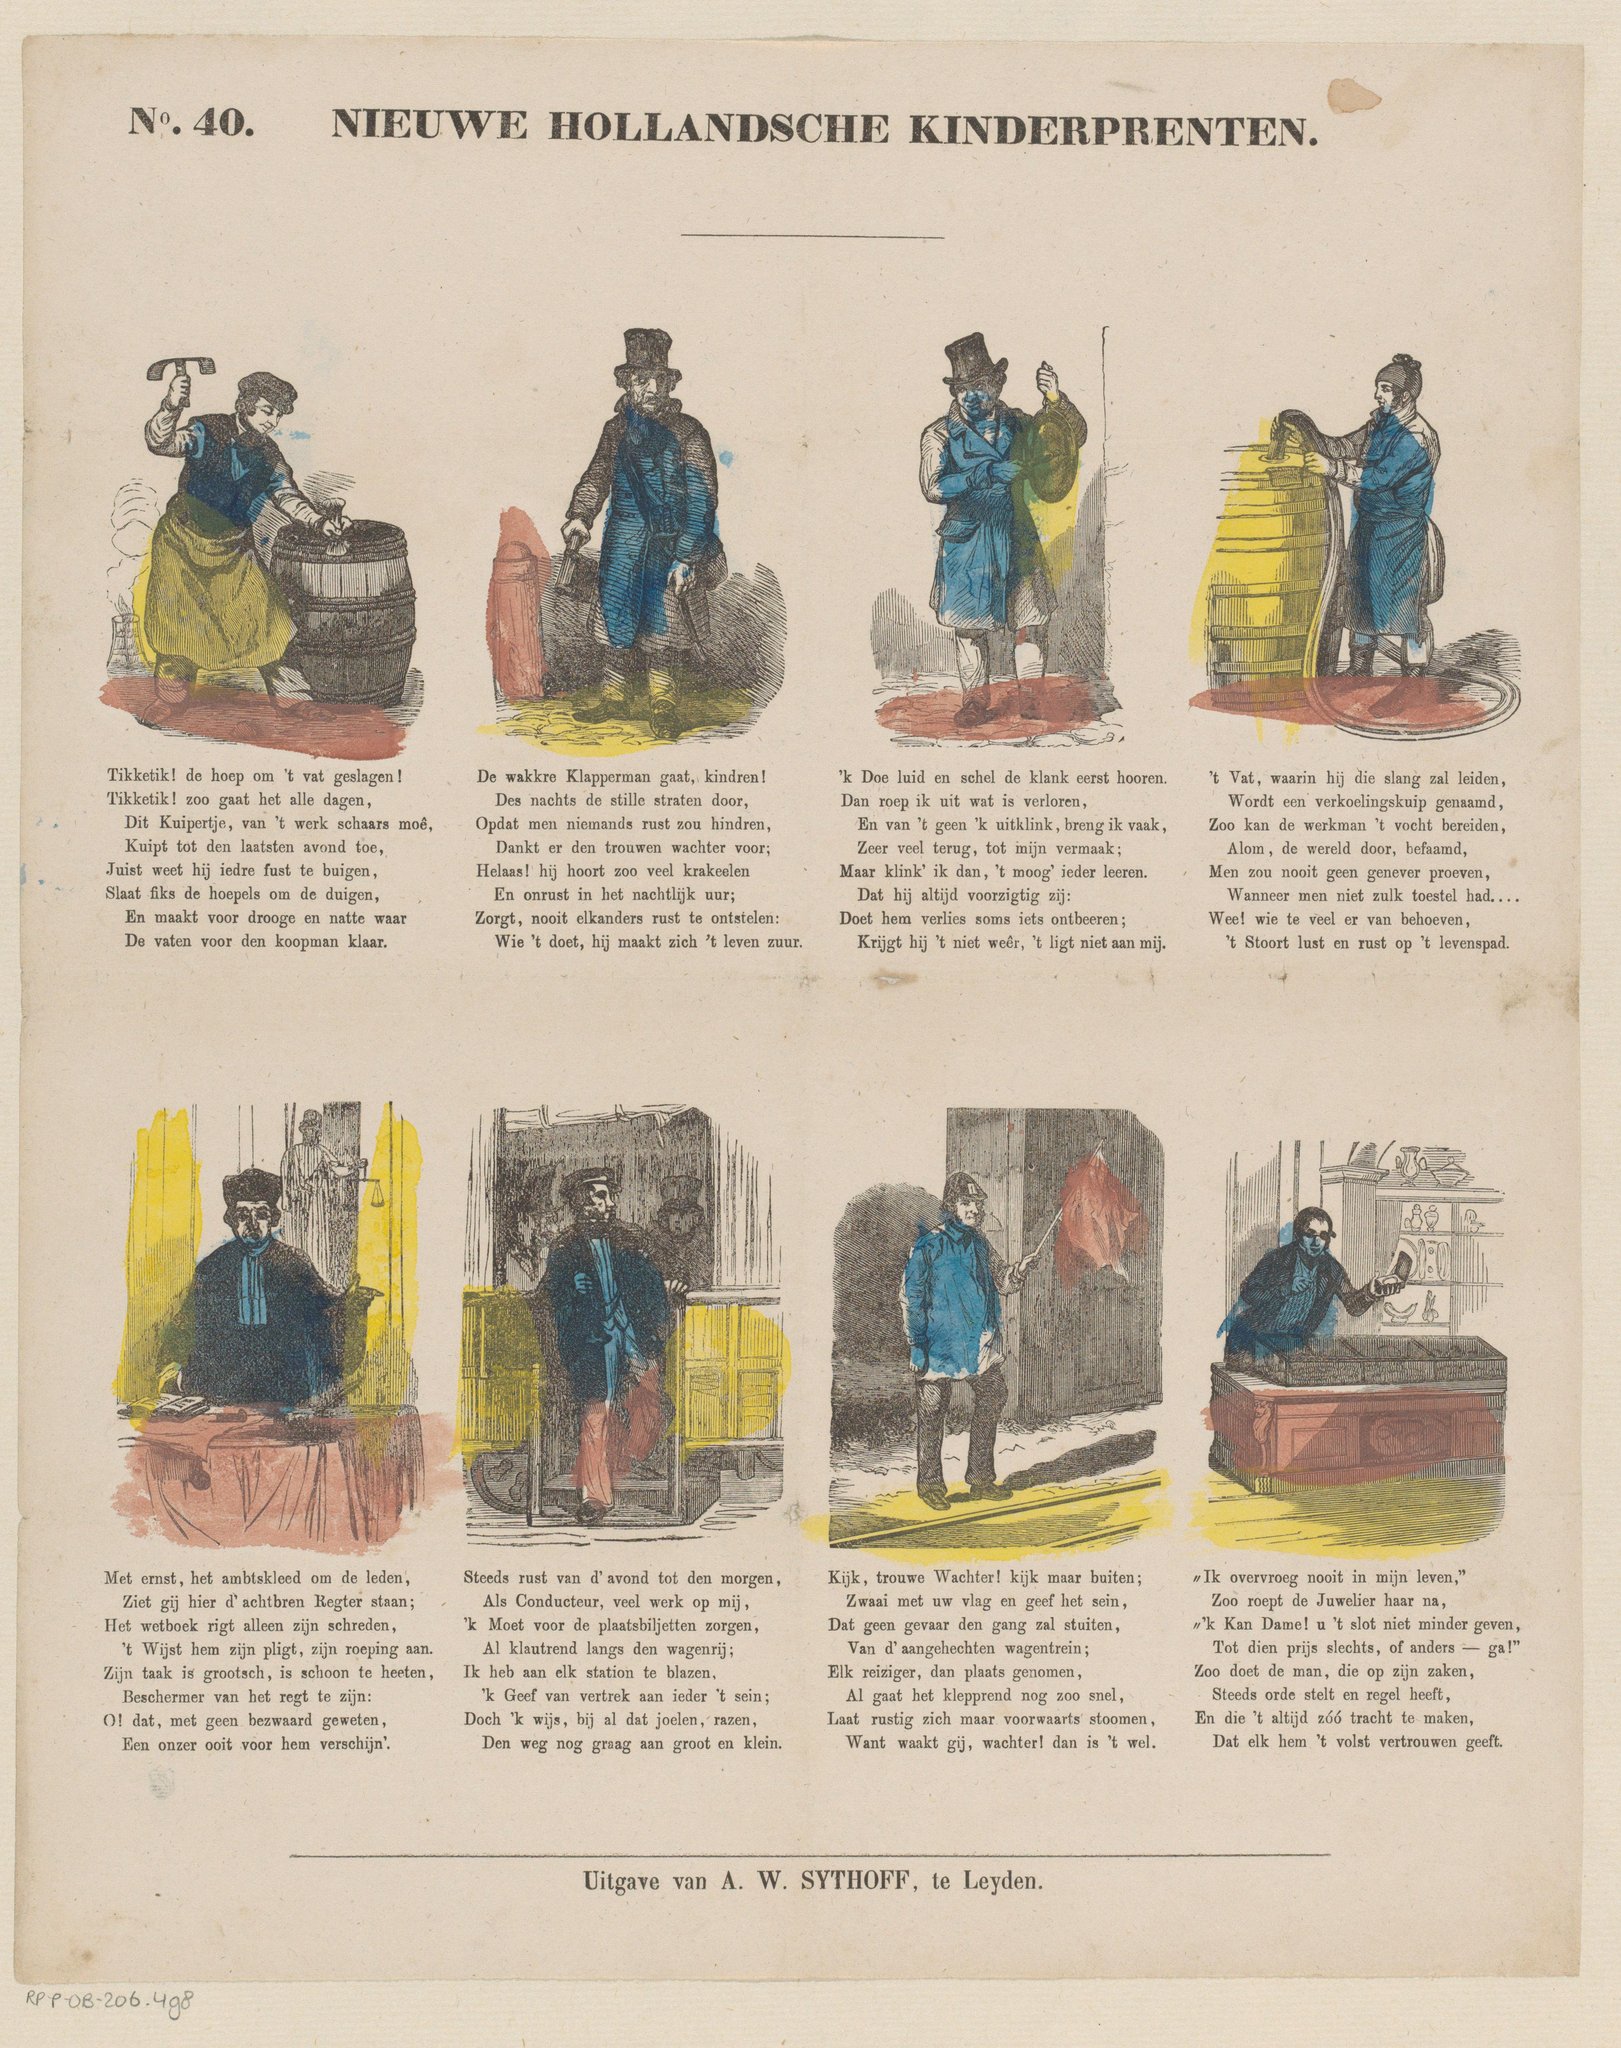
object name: print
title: Tikketik! de hoep om 't vat geslagen! [(...)]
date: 1861-1929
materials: paper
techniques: colour, letterpress printing, engraving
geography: leiden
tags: craft-production, skilled handiwork, law and jurisprudence (+ judge), crafts and industries, guard duty, keeping sentry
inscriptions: collector's mark: Lugt 2760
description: Blad met 8 voorstellingen van ambachtslieden en beroepen, zoals kuiper, rechter en wachter. Onder elke voorstelling een achtregelig vers. Genummerd linksboven: No. 40.